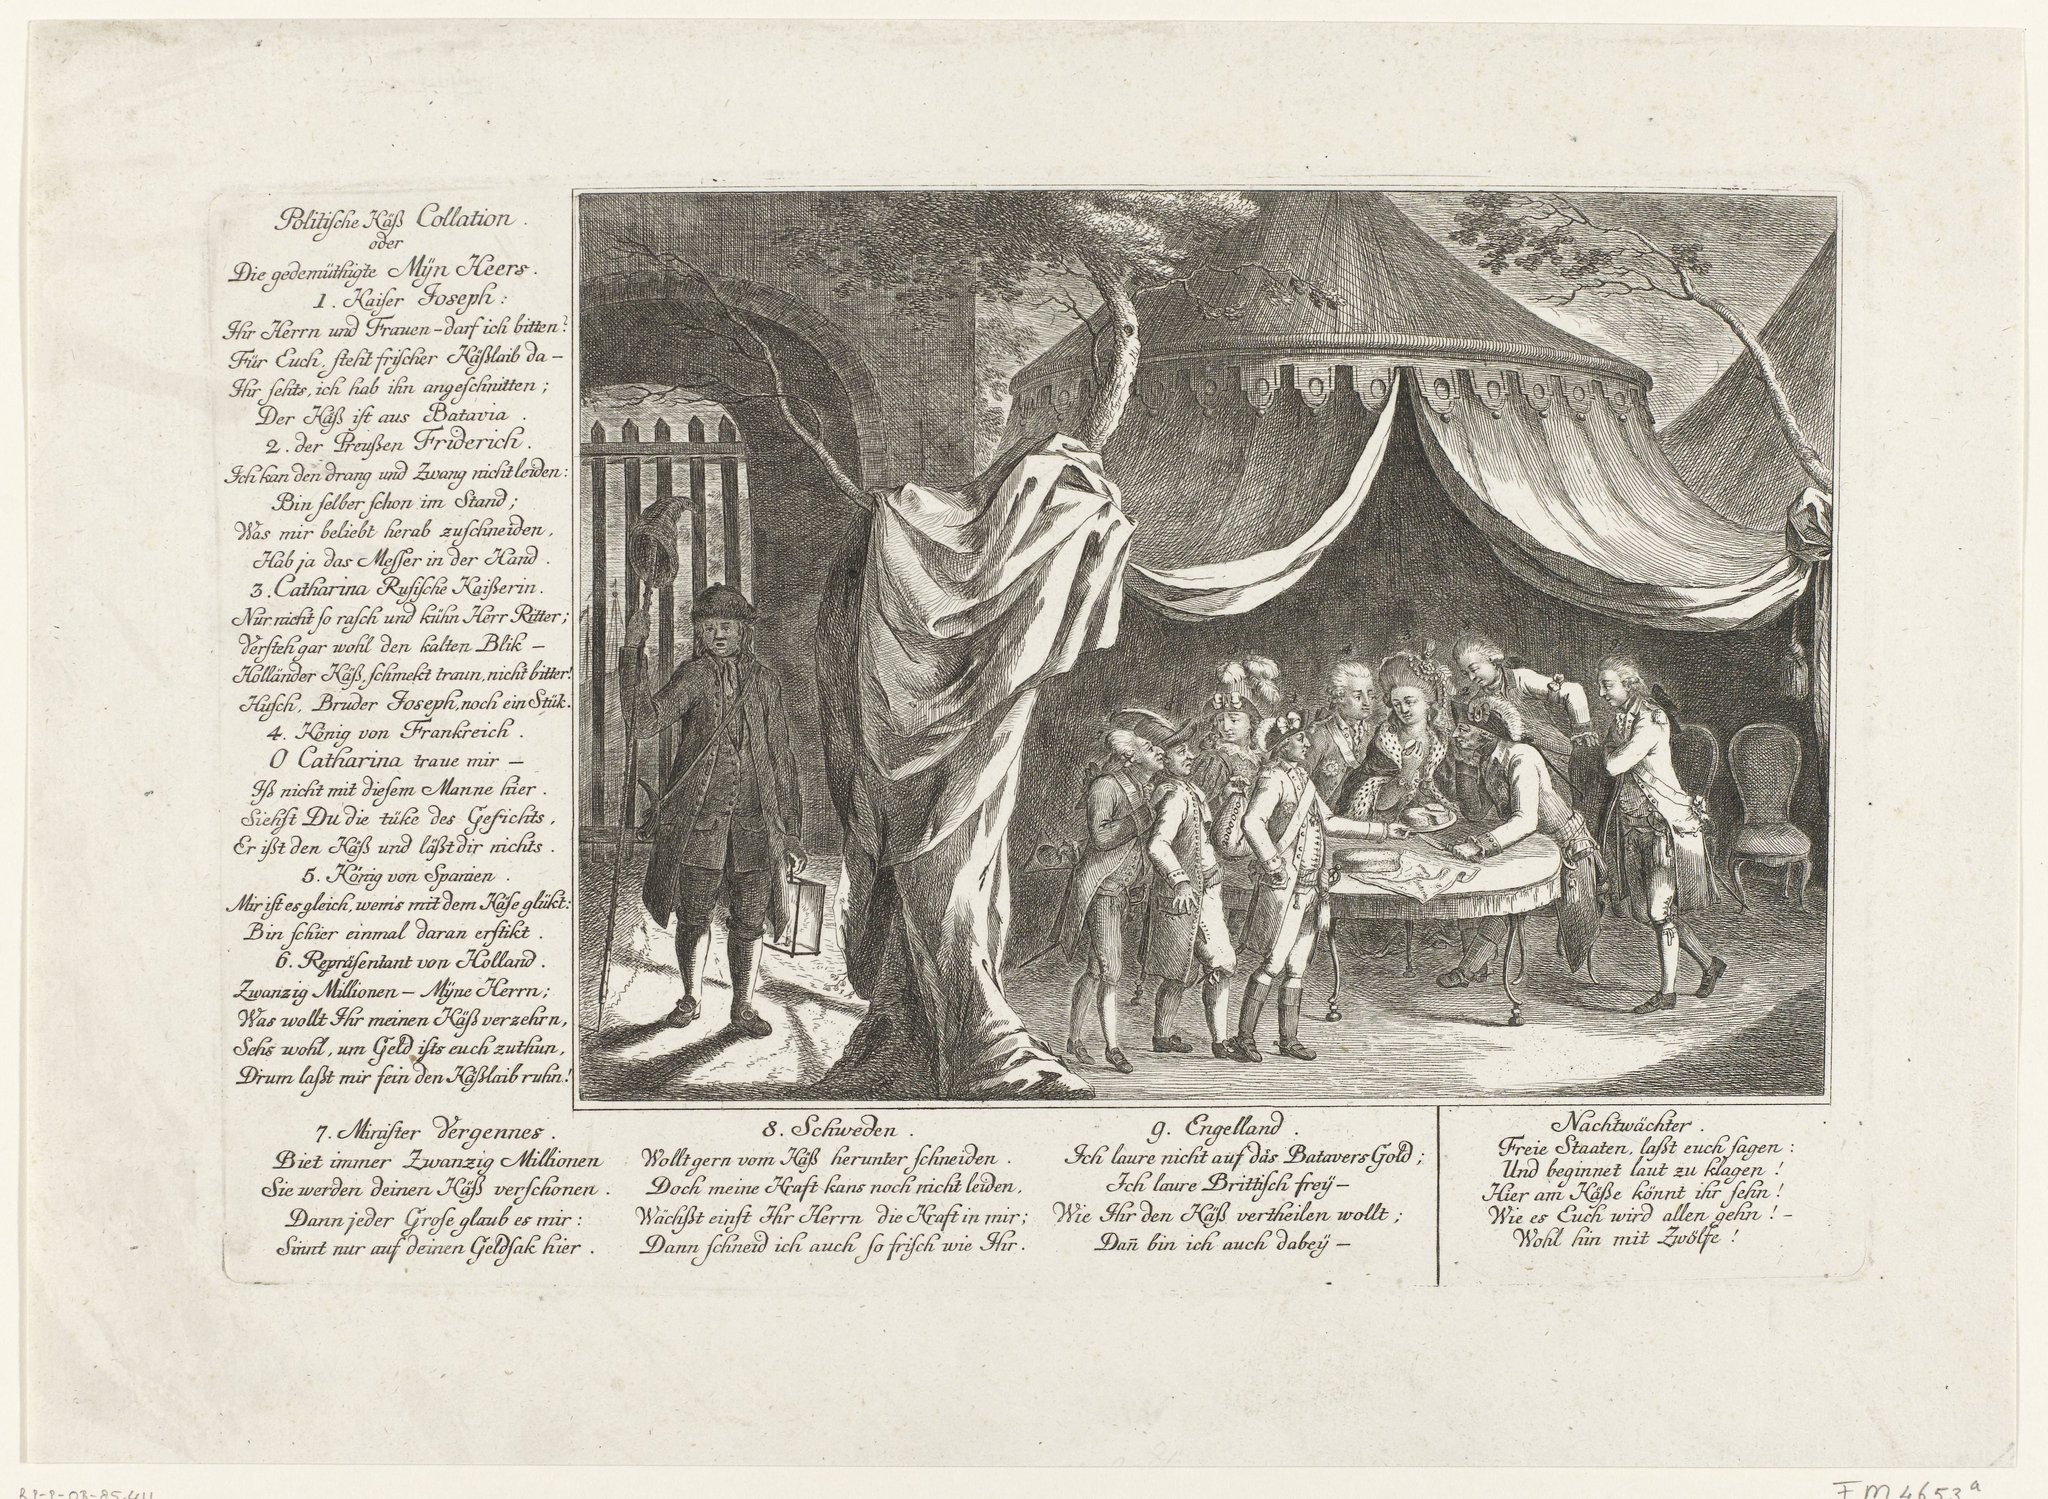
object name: print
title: Politische Käß Collation oder Die gedemüthigte Mijn Heers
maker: Anonymous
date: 1785-1786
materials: paper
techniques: engraving, etching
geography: germany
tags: vienna, jozef ii (duits keizer), berlin, frederick ii (king of prussia), catharina de grote, paris, lodewijk xvi (koning van frankrijk), (military) camp with tents, cheese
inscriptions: collector's mark: Lugt 2228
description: Spotprent op de vrede gesloten te Parijs waarmee een eind kwam aan de Keteloorlog, de twisten tussen Nederland en de Oostenrijkse keizer Jozef II, 8 november 1785. Nederland betaalde 8,5 miljoen gulden en accepteerde andere vernederende voorwaarden. In een tent verdeelt keizer Jozef een Hollandse kaas onder Frederik van Pruisen, Catharina de Grote, Lodewijk XVI en vertegenwoordigers van Zweden, Spanje, en Engeland. De Hollander beklaagt zich over zijn lot. Links een nachtwachter met een lantaarn die de andere landen waarschuwt dat hun hetzelfde lot kan treffen. Links en onder de voorstelling een vers in tien coupletten in het Duits.